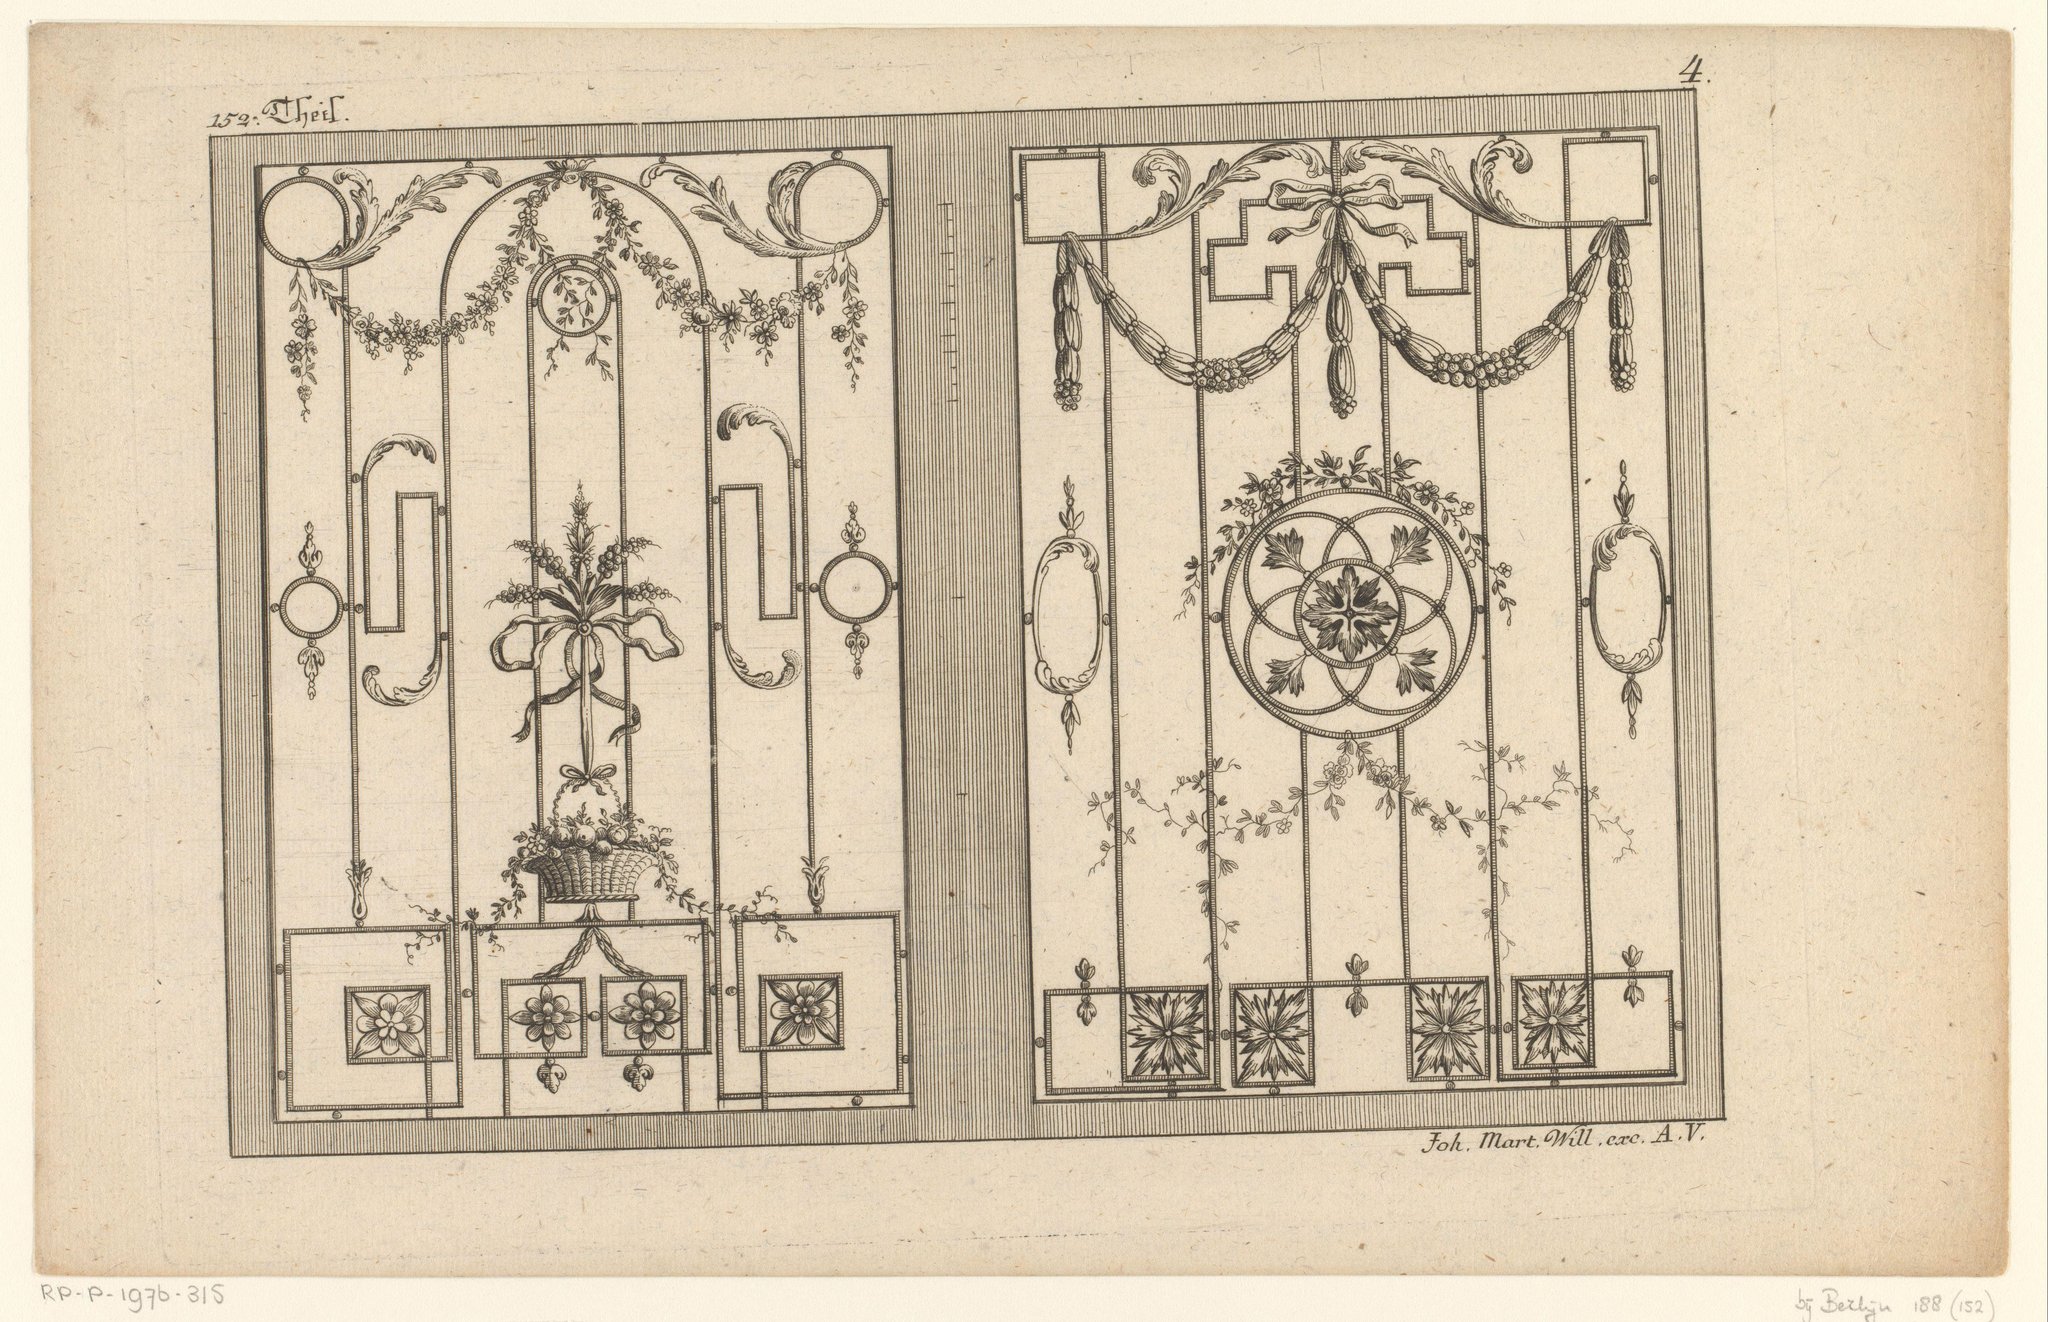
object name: ornament print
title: 152. Theil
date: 1737-1806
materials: paper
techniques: etching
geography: augsburg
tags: welding (industrial process), fence, wall, paling, ornament ~ festoon, garland, flowers ~ ornament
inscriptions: collector's mark: Lugt 2228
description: Twee smeedijzeren hekwerken met guirlandes, blad- en bloemmotieven en een mand met bloemen.